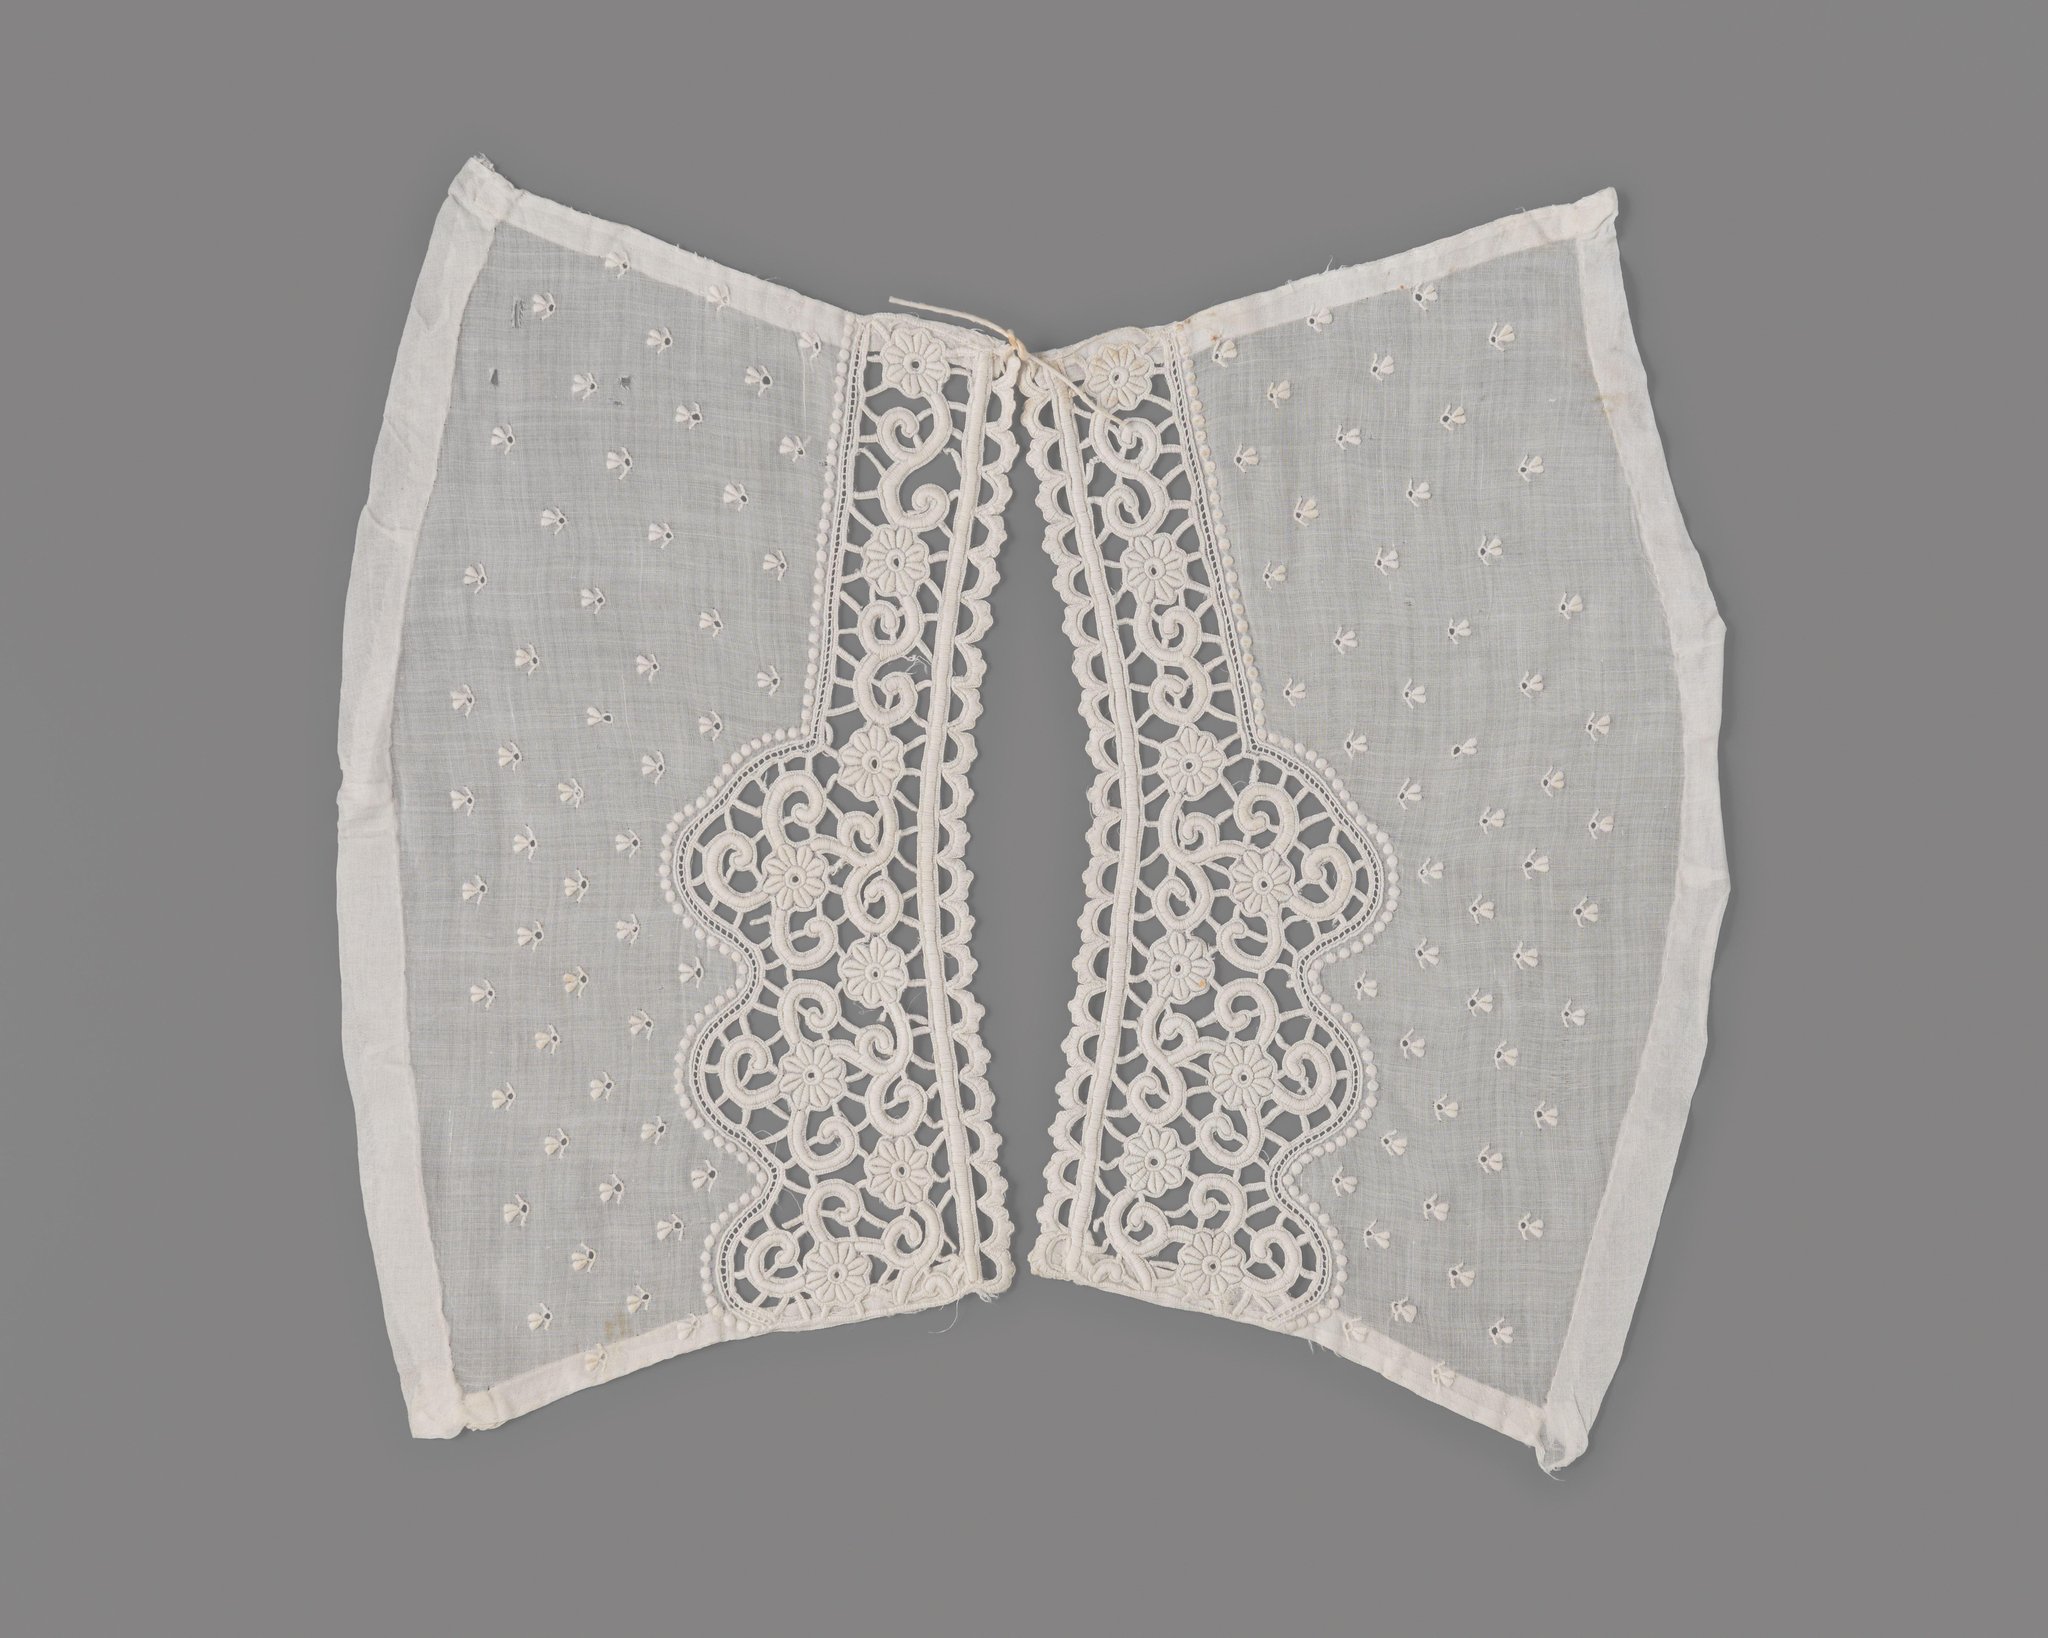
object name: cuff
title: Manchet met rand met floraal motief in Engels borduurwerk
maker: Anonymous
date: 1800-1920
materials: linen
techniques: english embroidery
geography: western europe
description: Manchet met deels golvende rand met floraal motief in Engels borduurwerk.